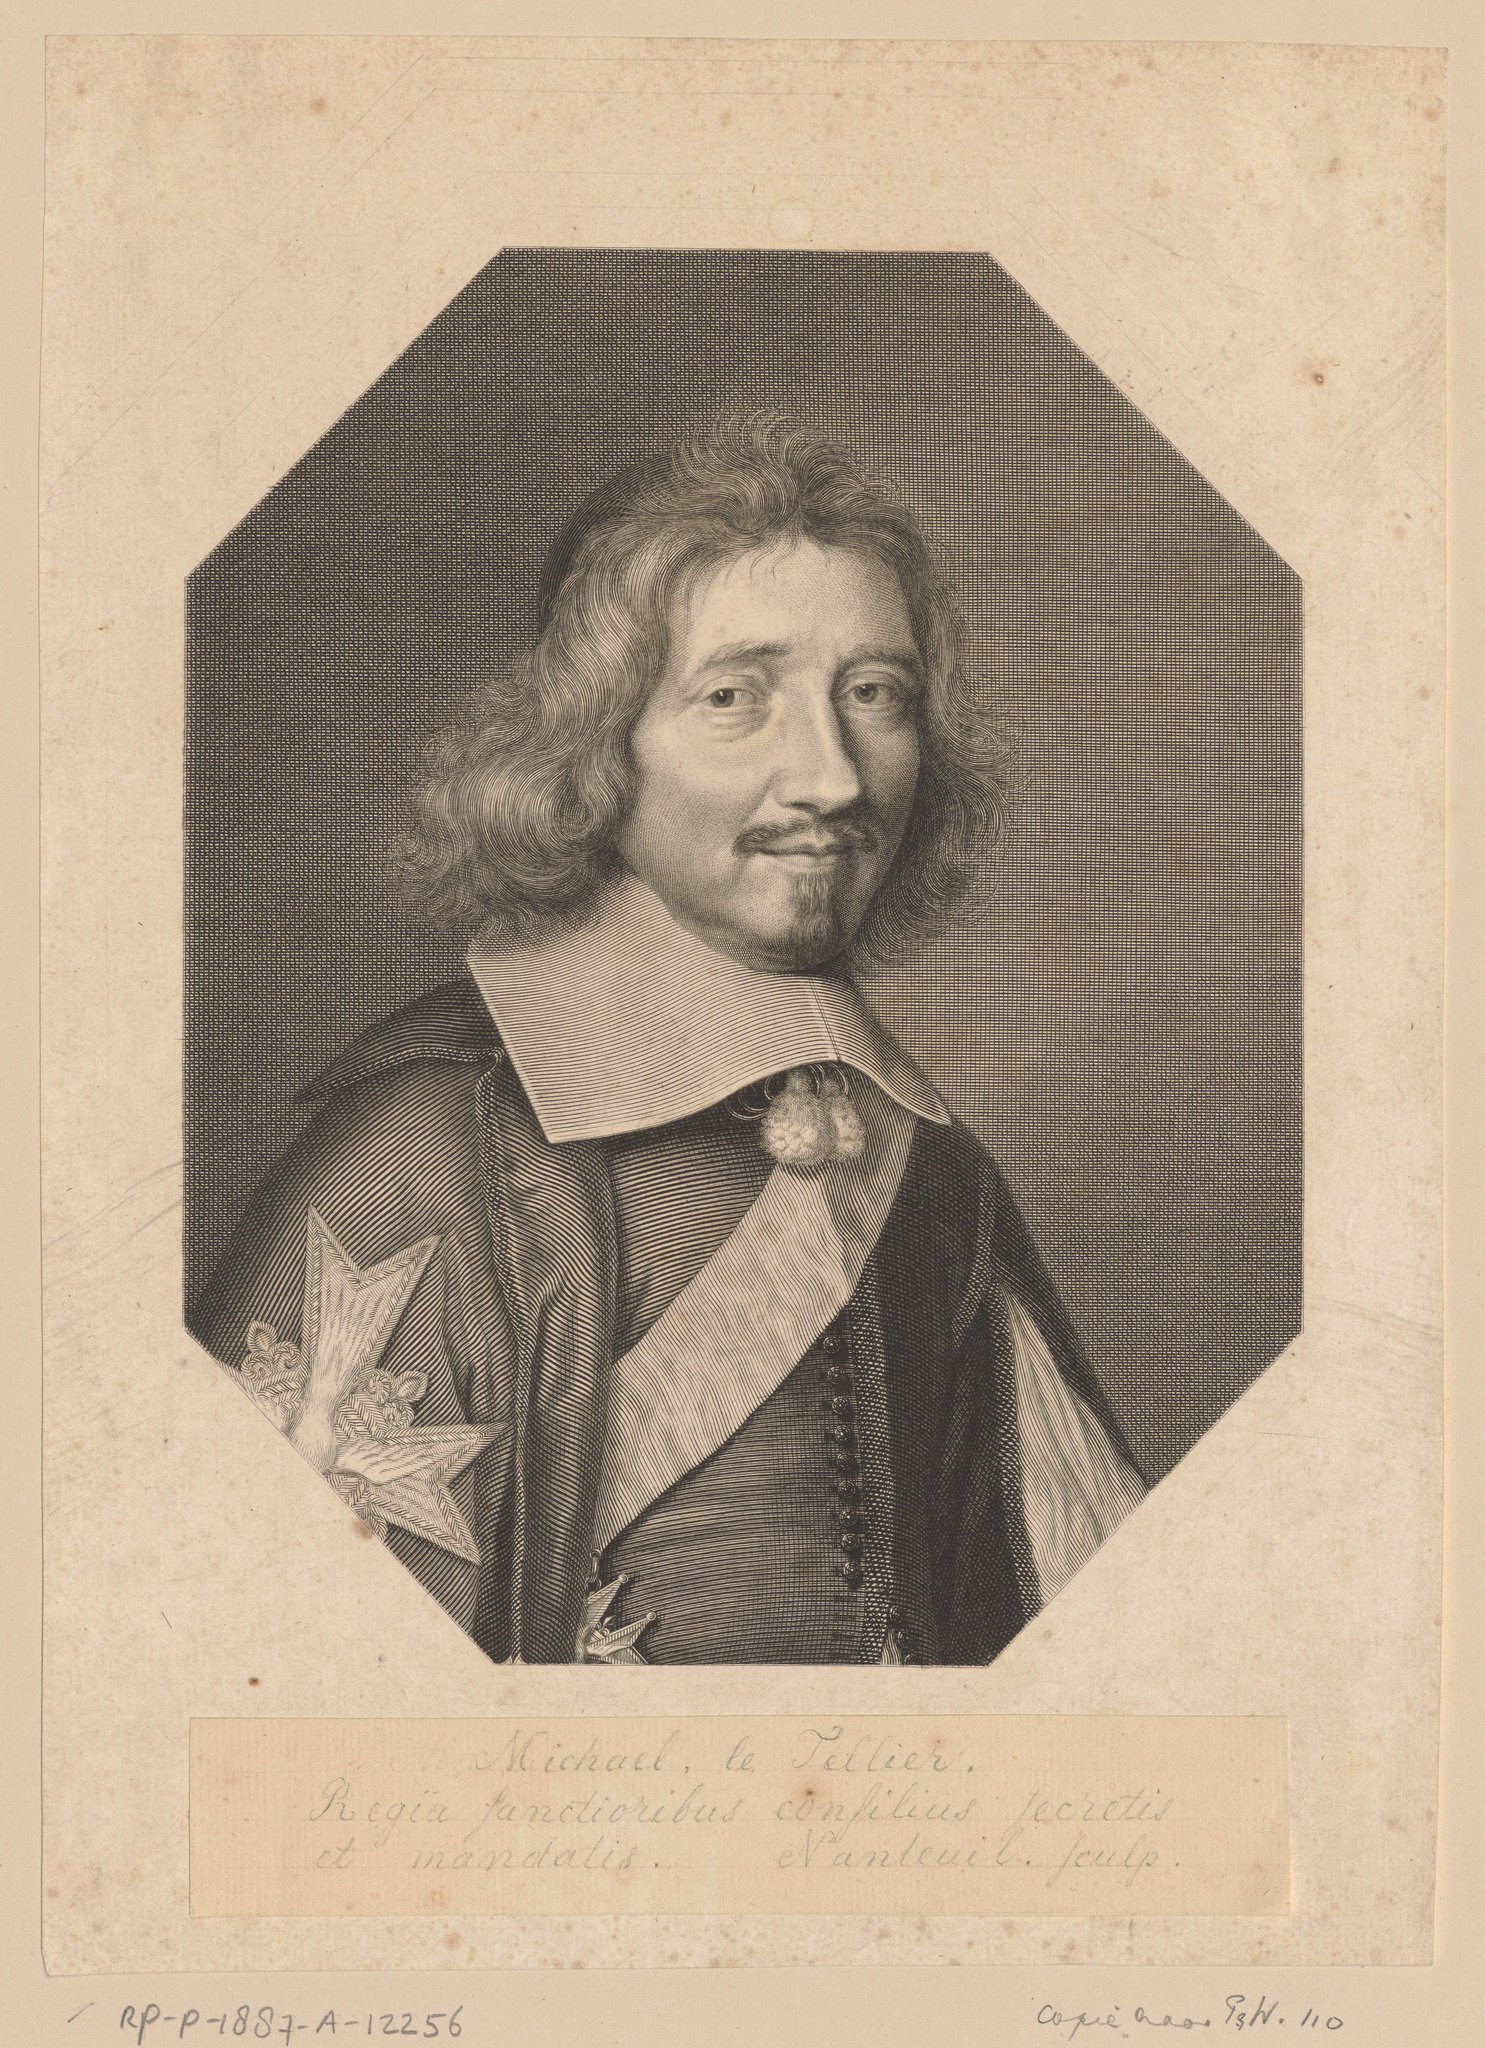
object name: print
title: Portret van Michel Le Tellier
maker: robert nanteuil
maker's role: print maker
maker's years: 1623-1678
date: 1658-1699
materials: paper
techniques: engraving, etching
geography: france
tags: paris, michel le tellier, historical persons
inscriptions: collector's mark: Lugt 2228